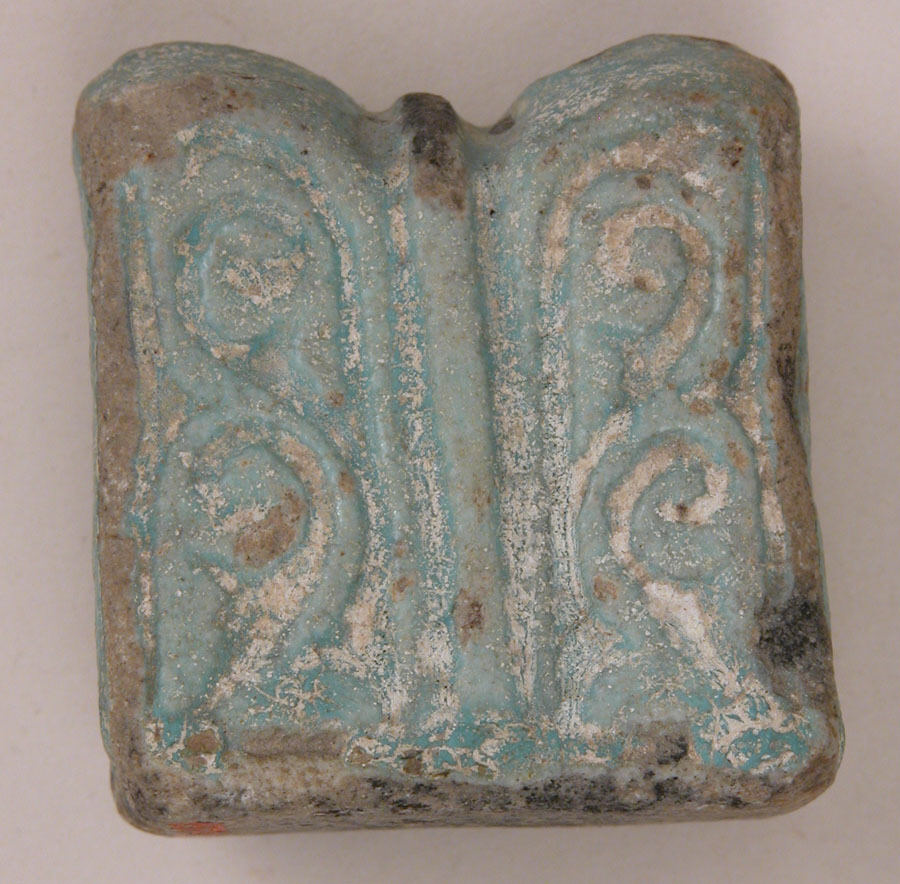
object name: chess piece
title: Chess Piece, Rook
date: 1001-1200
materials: earthenware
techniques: glazing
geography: western islamic lands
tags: chess,games